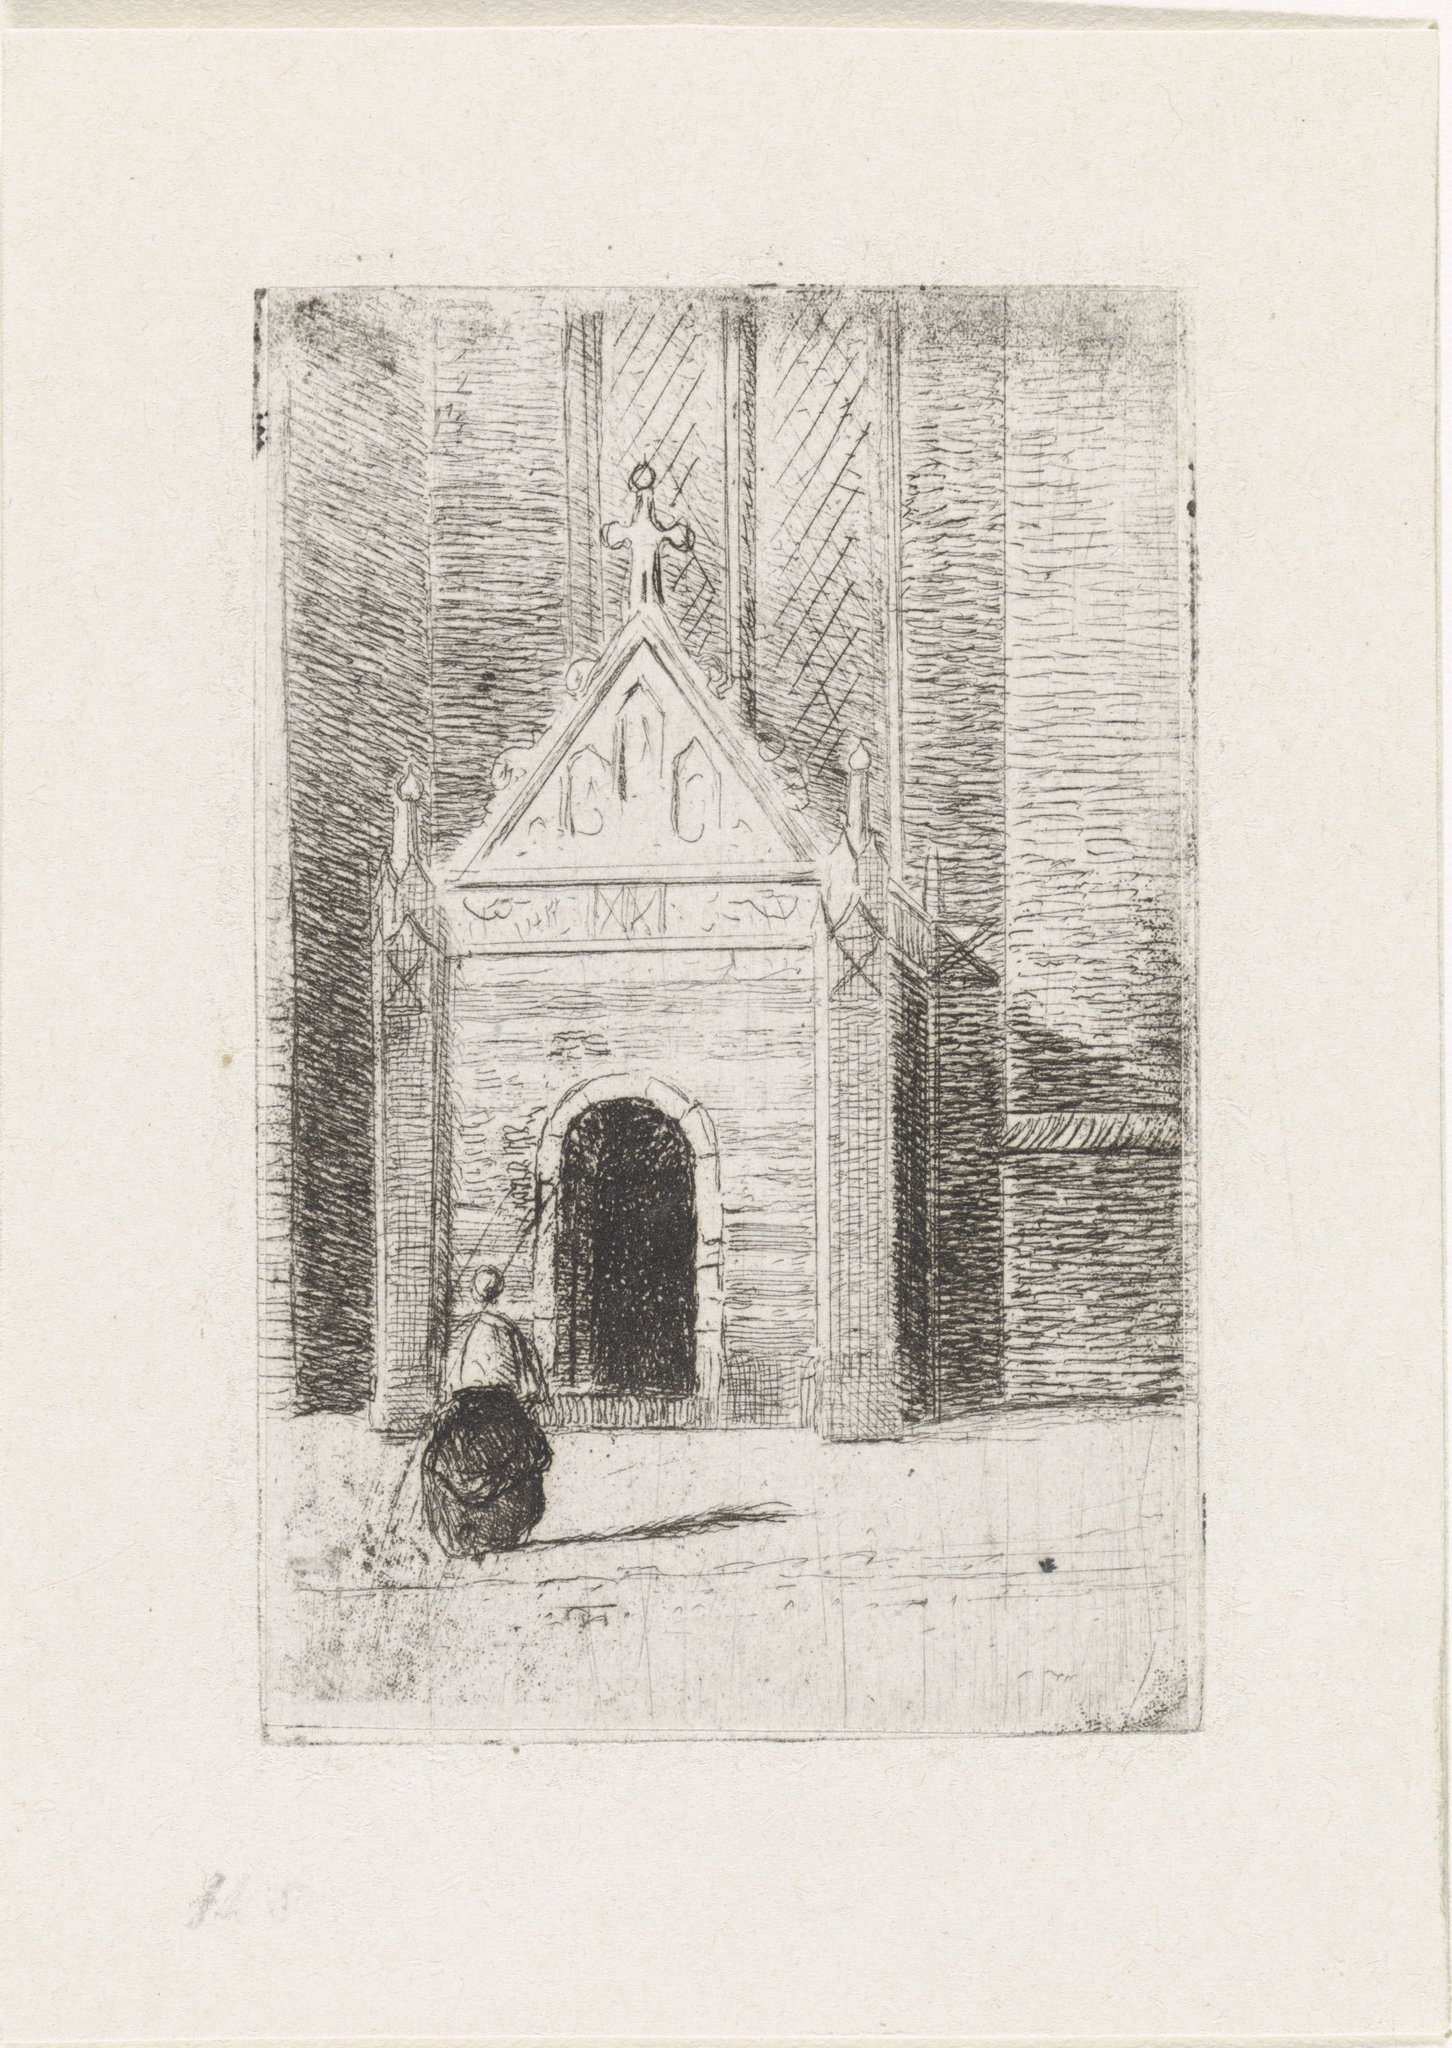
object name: print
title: Vrouw bij een kerkportaal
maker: gijsbertus johannes verspuy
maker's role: print maker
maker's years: 1823-1862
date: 1833-1862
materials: paper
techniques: etching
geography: netherlands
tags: parts of church exterior and annexes: portal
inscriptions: collector's mark: Lugt 2228